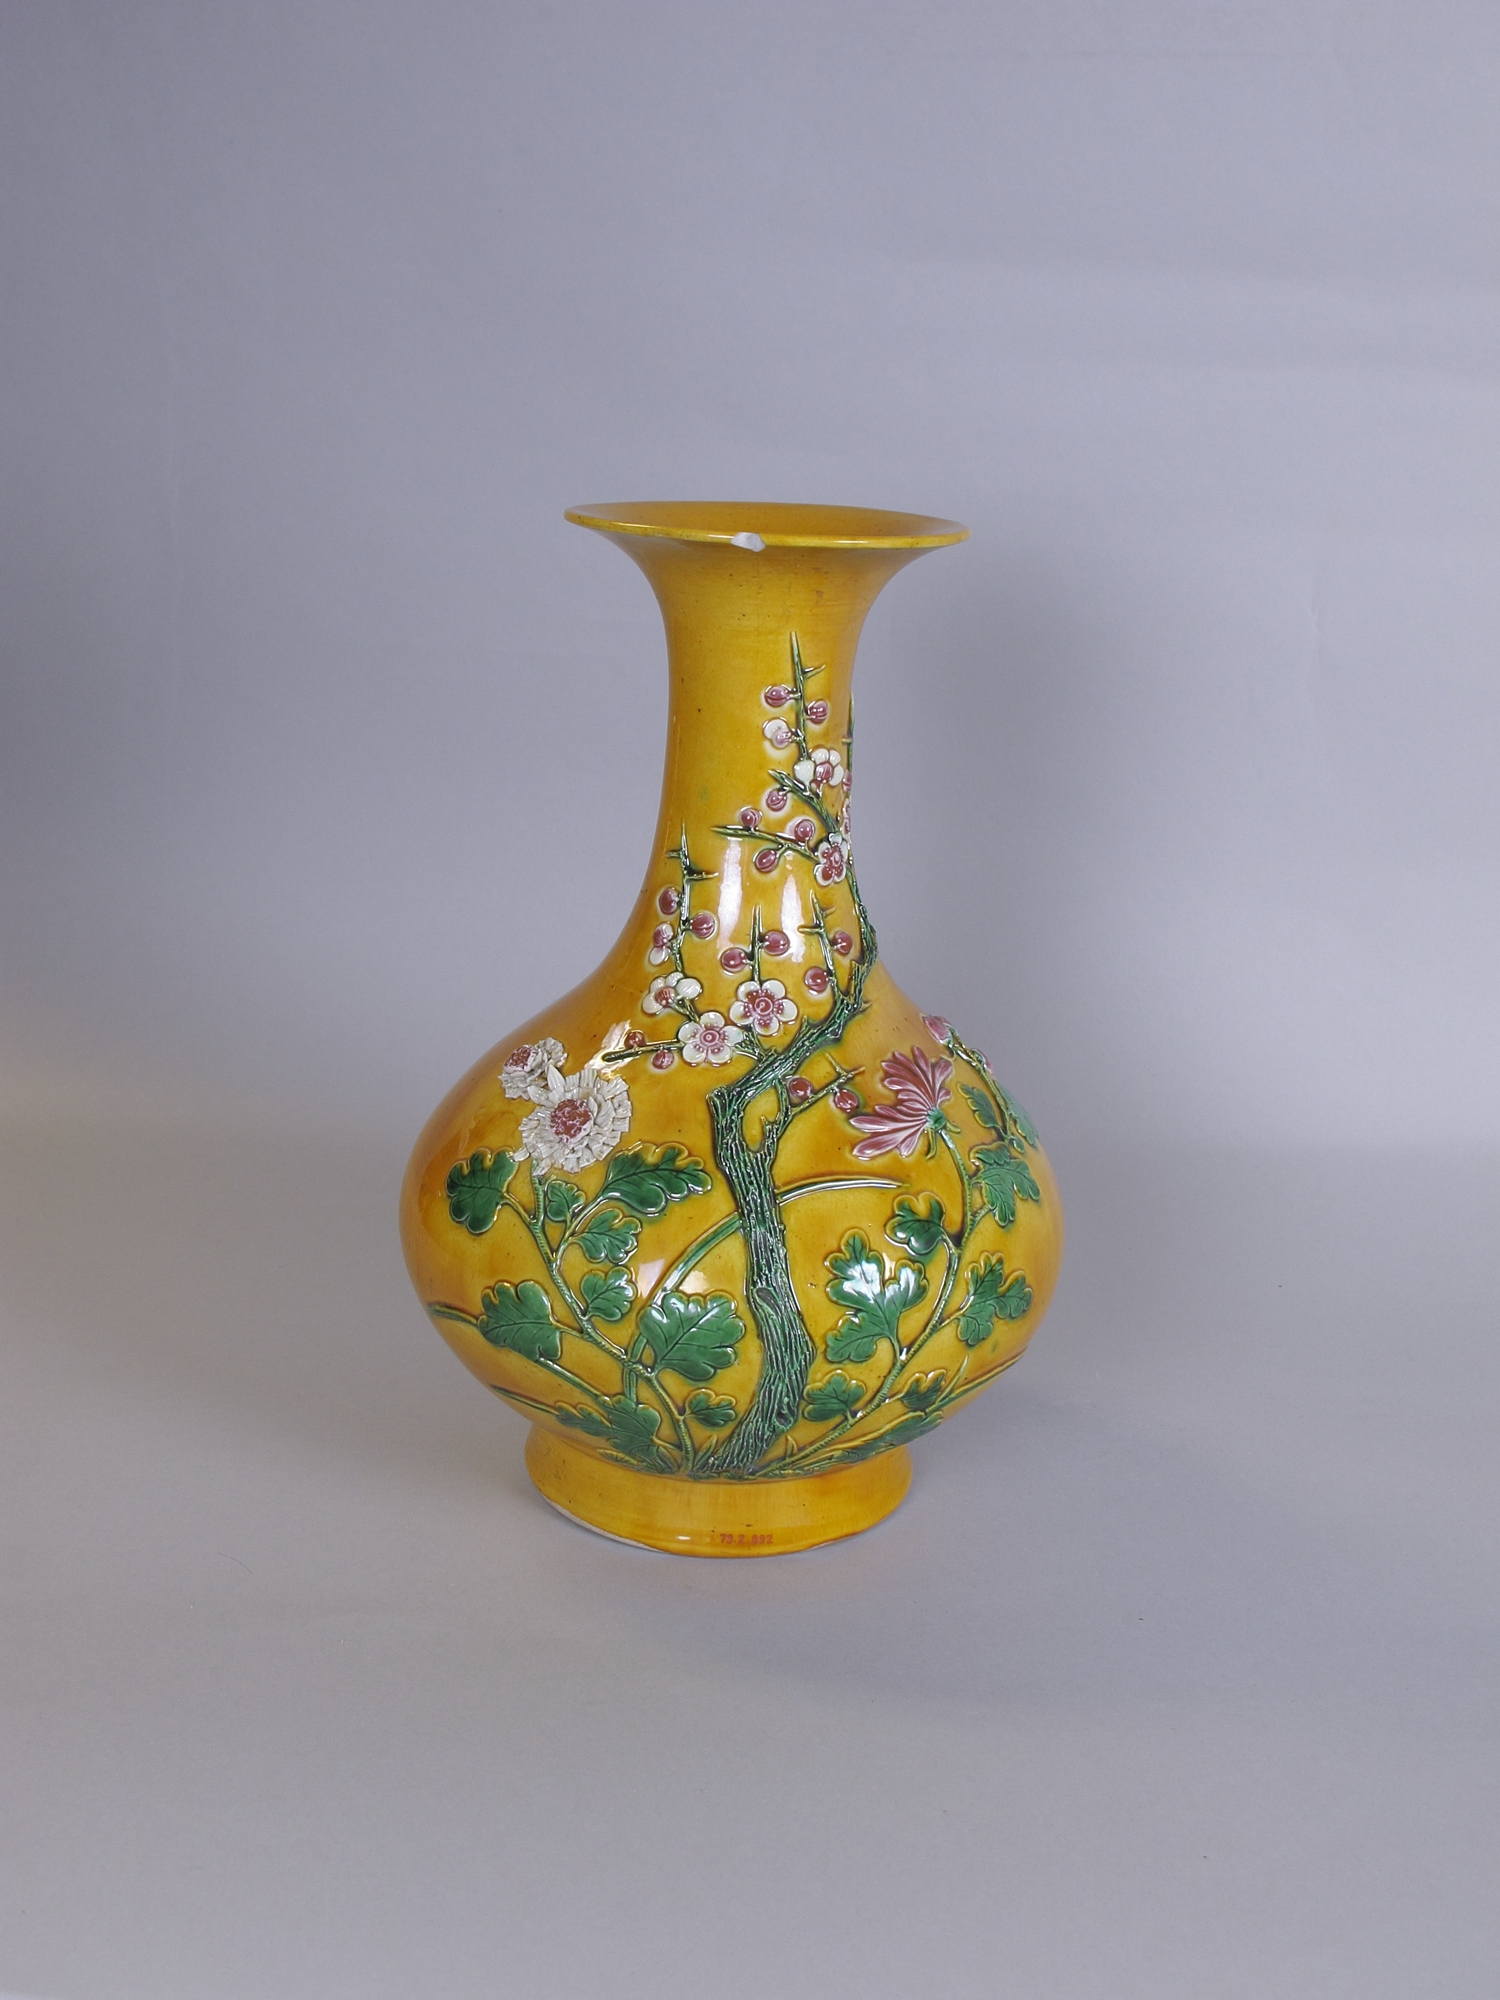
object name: vase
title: Vase with flowers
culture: chinese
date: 1801-1833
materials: glaze, porcelain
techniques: polychrome, relief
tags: flowers,leaves